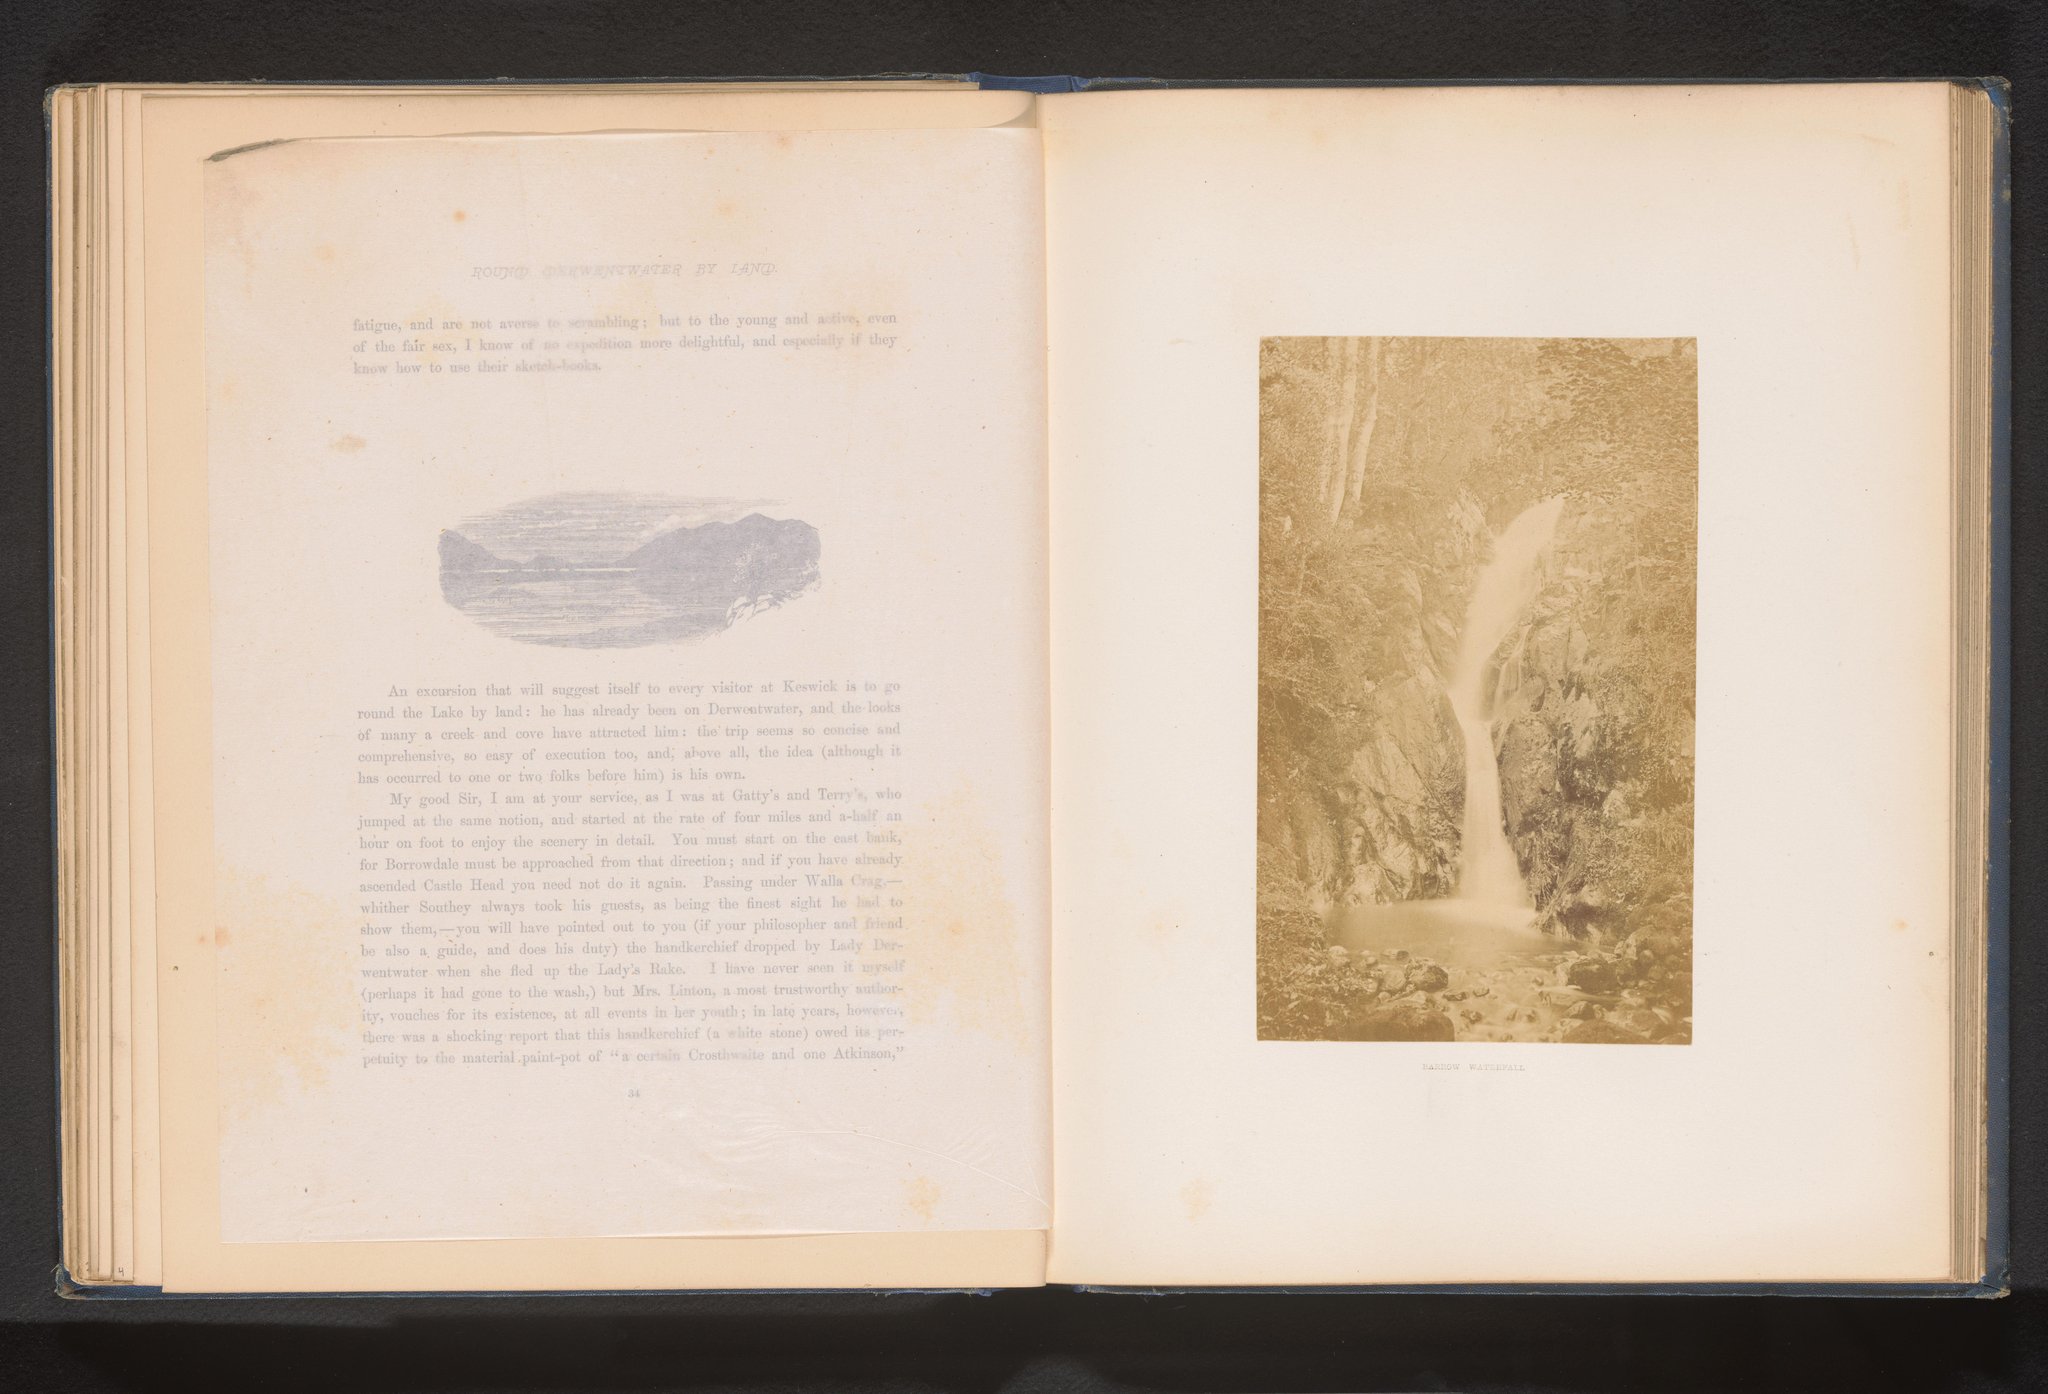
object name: page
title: Gezicht op een waterval in het Lake District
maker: r.j. sproat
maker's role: fotograaf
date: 1857-1870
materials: photographic support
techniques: albumen print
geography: lake district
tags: waterfall